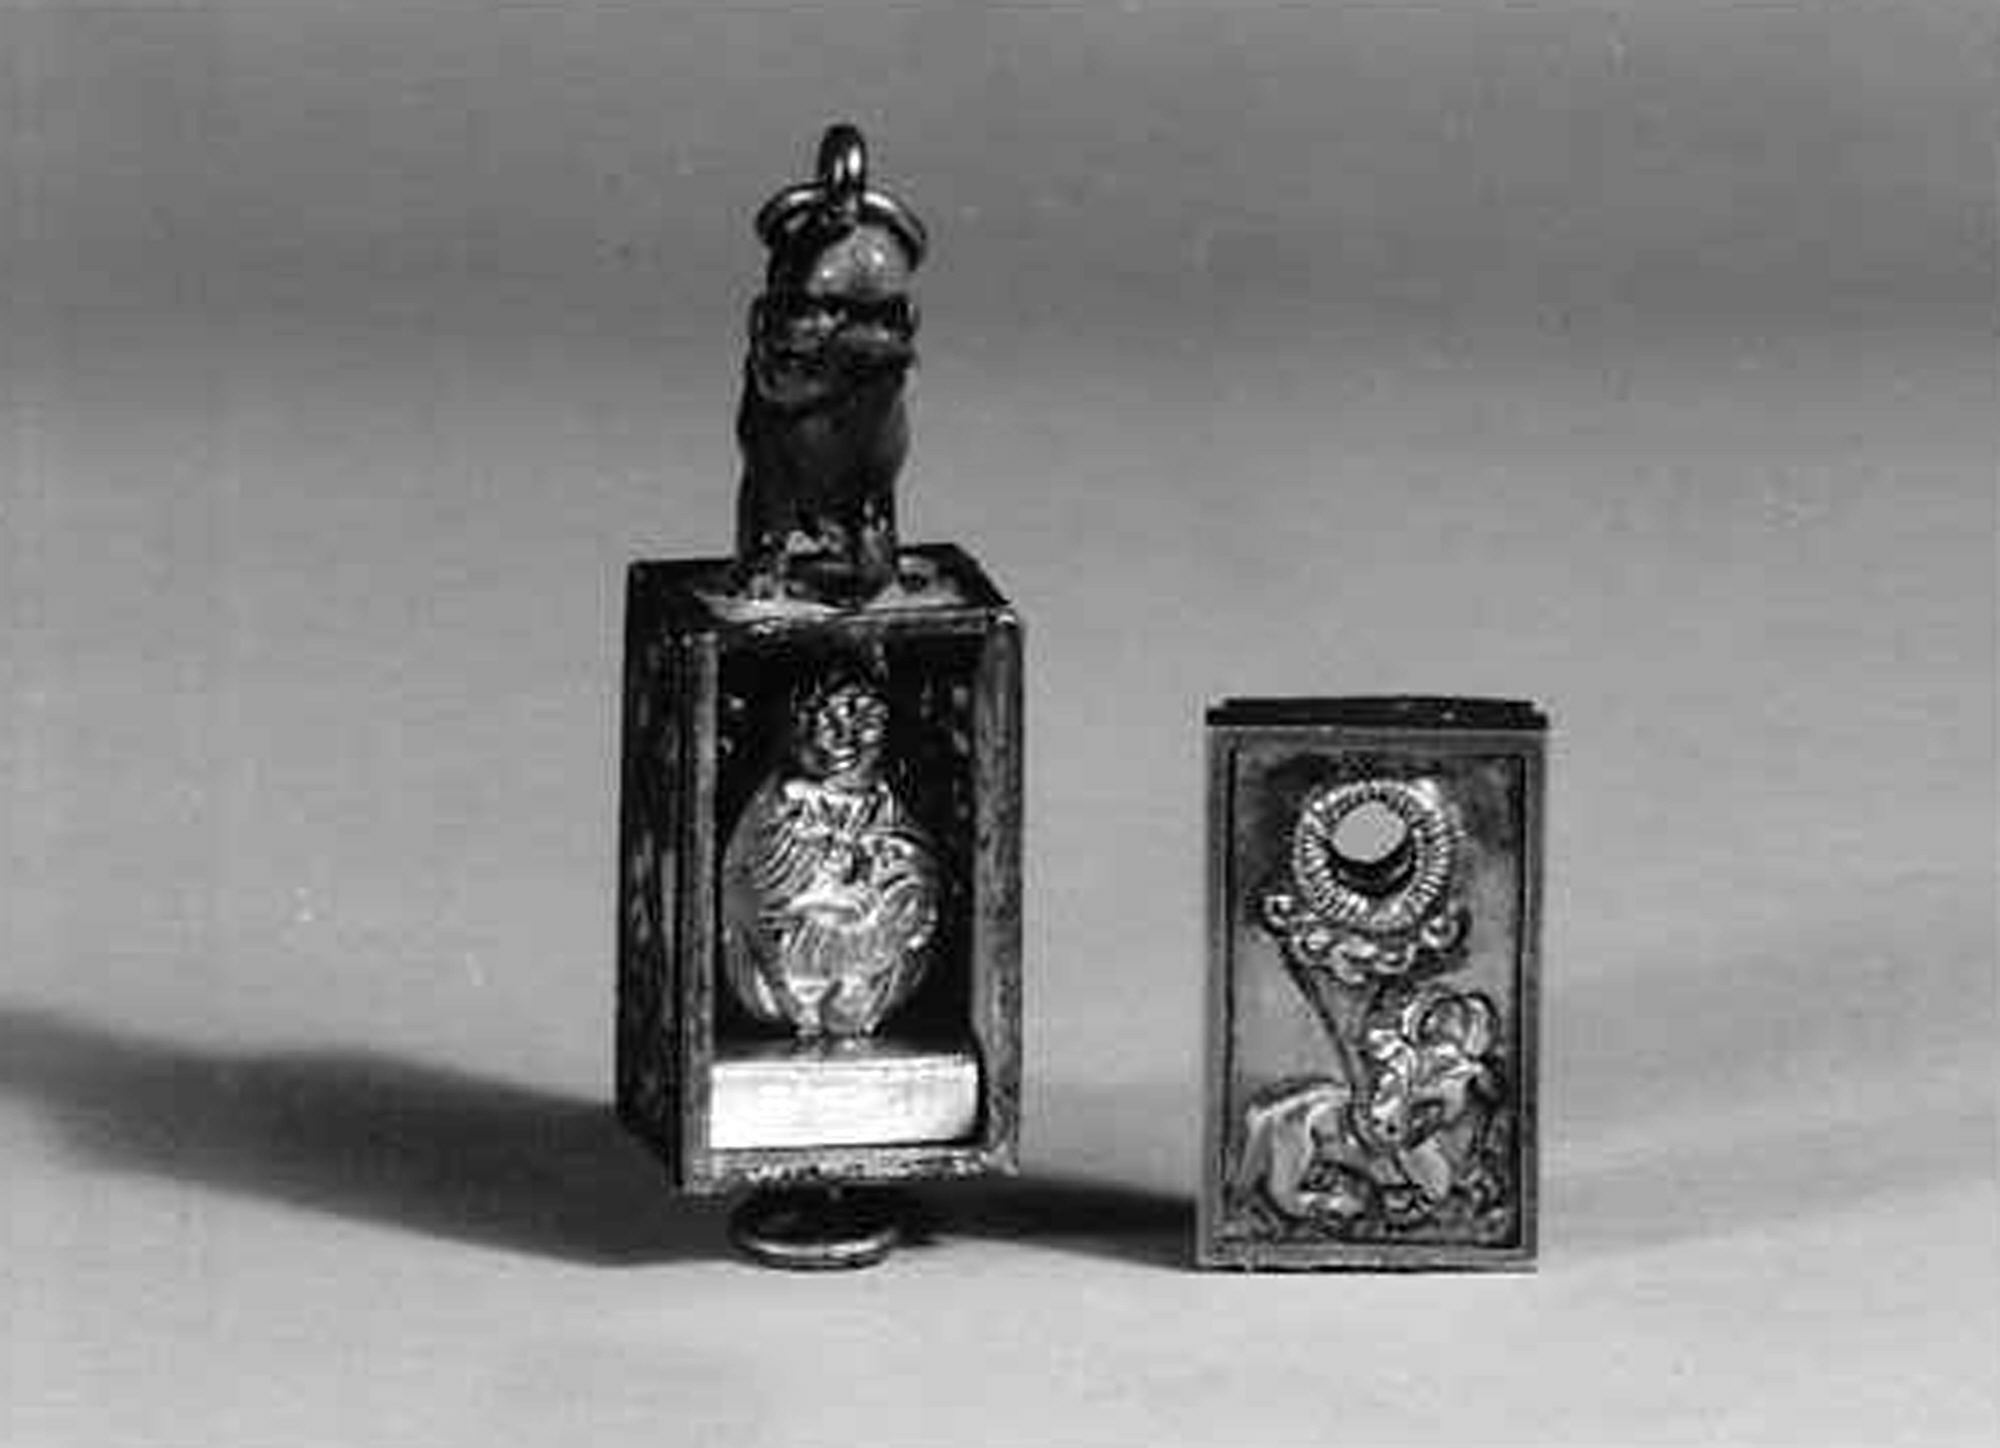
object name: pendant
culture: japanese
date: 1867-1933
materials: enamel, gilt, silver